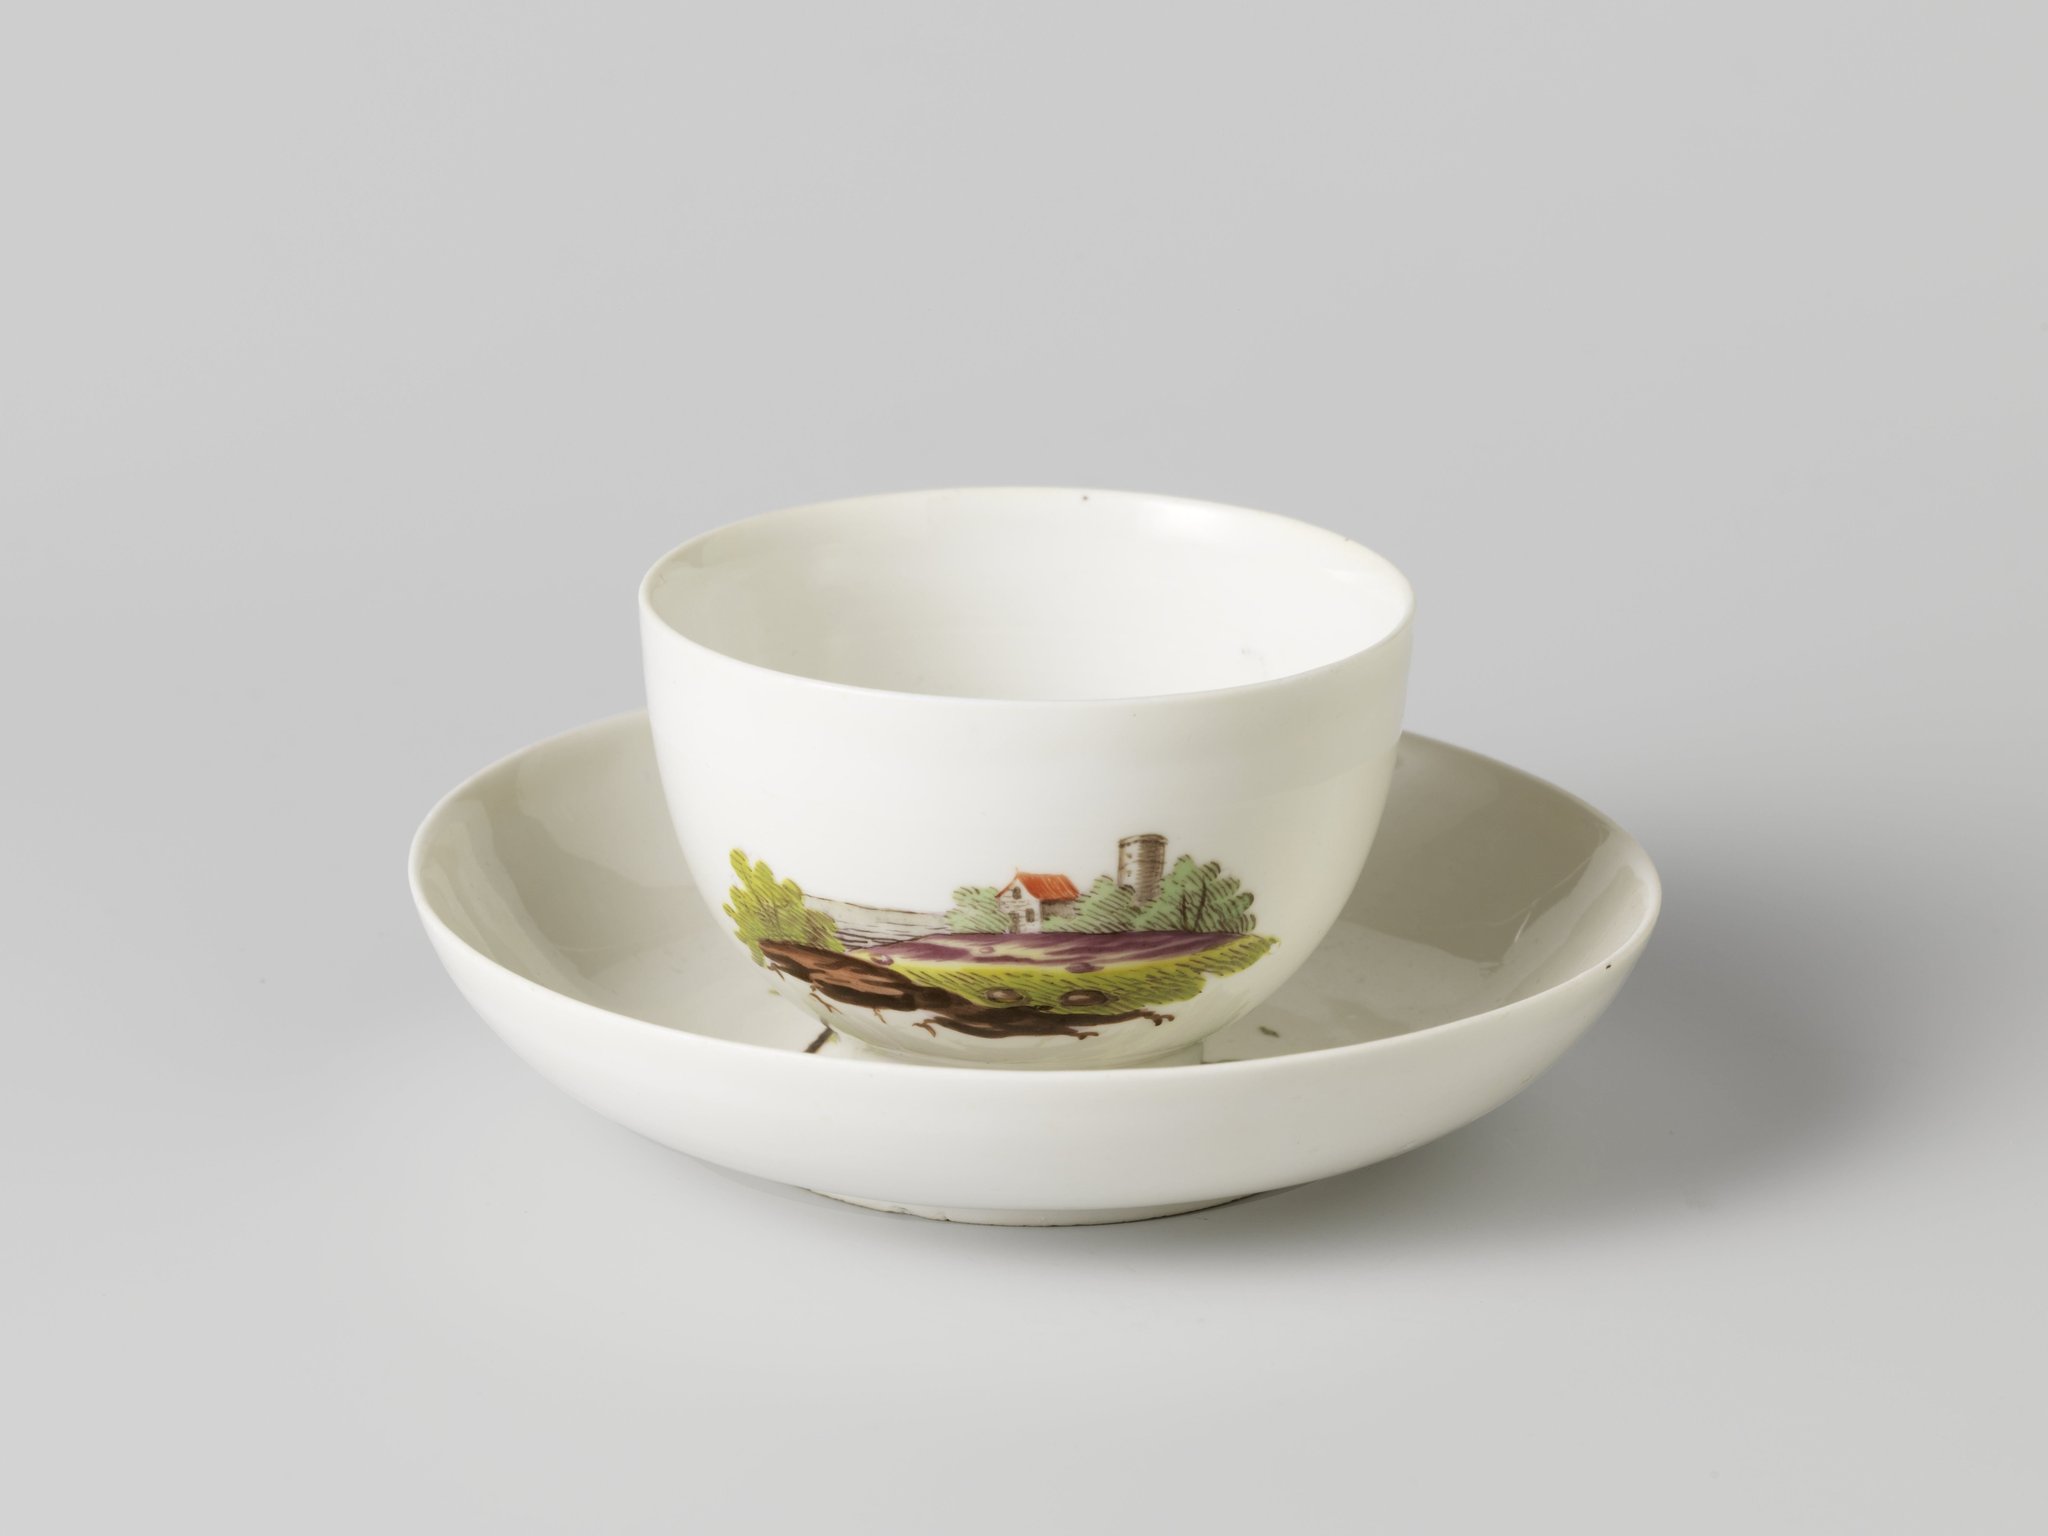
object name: kop en schotel, kop en schotel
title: Kop en schotel met veelkleurig landschap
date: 1759-1771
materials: porcelain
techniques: painted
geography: weesp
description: Tea cup and saucer. Porcelain. Weesp, c. 1760 - 1770. Factory of Betram, Count Gronsveld-Diepenbroick.